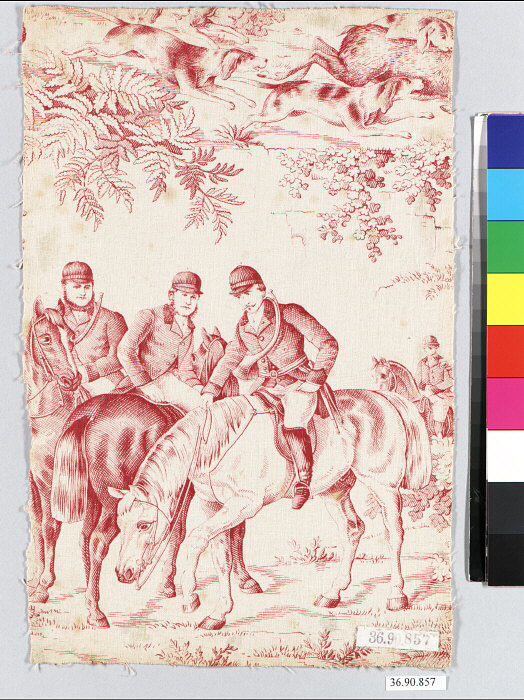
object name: piece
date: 1801-1900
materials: cotton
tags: men,hunting,deer,dogs,horses,leaves